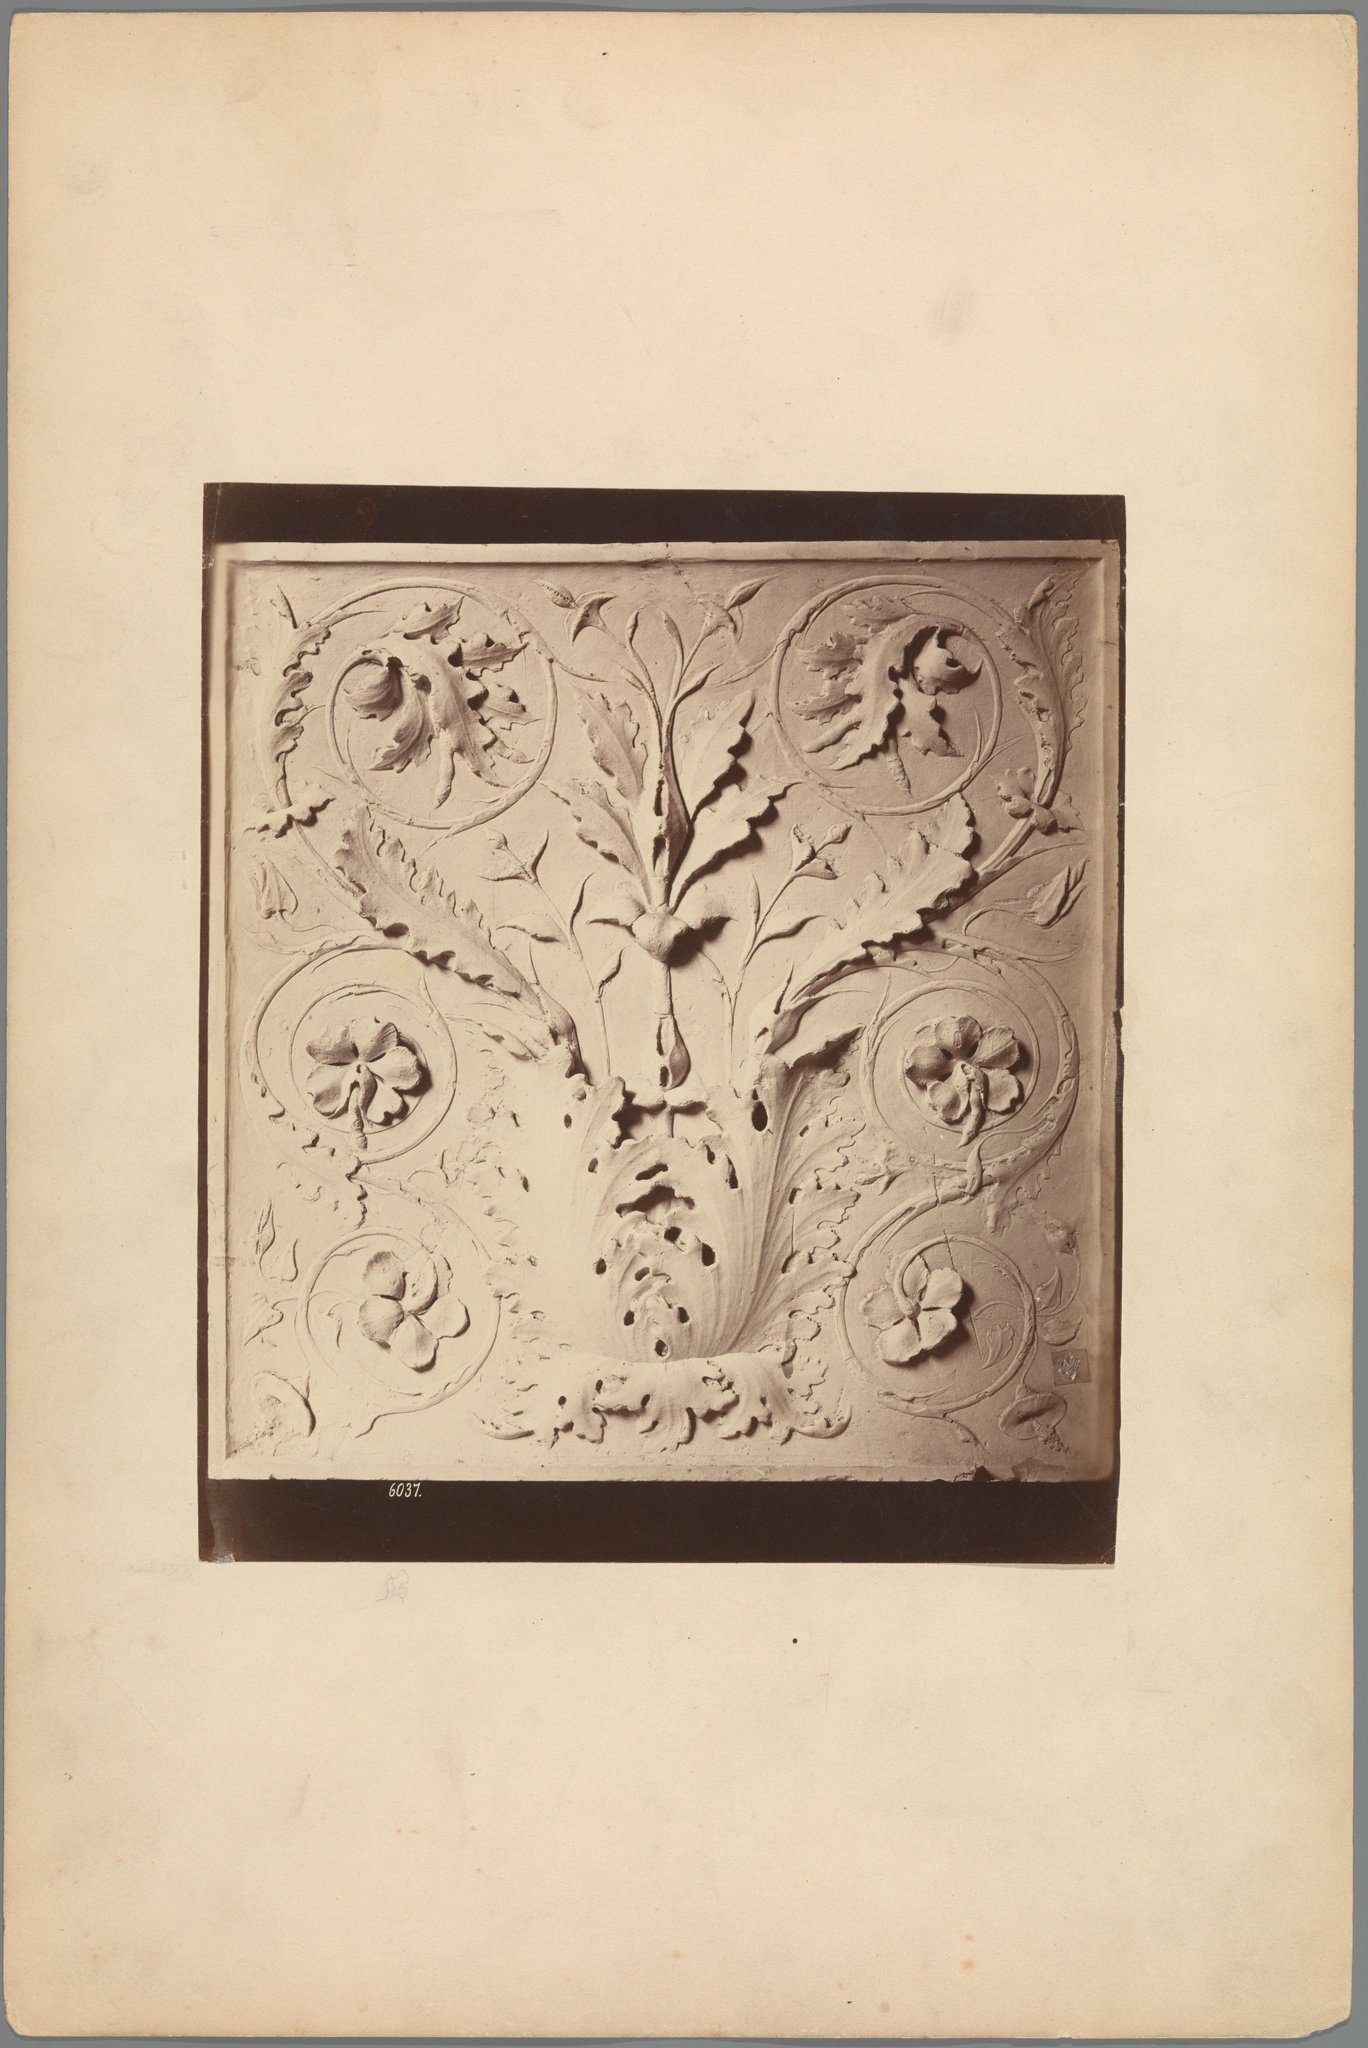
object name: photograph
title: Reliëf met blad en bloemmotieven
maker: Anonymous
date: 1875-1900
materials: cardboard, photographic support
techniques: albumen print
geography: europe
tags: ornament derived from plant forms, flowers ~ ornament, sculpture (+ relief ~ sculpture), europe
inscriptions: collector's mark: Lugt 3937, number: ‘6037.’